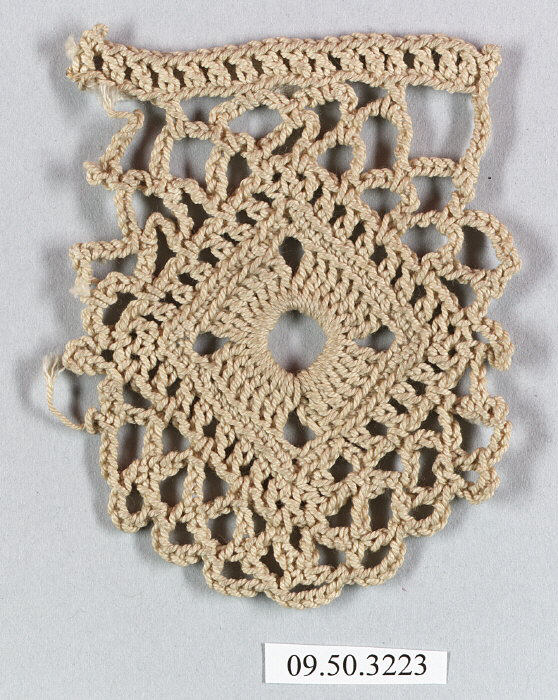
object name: sample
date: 1801-1900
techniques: crochet